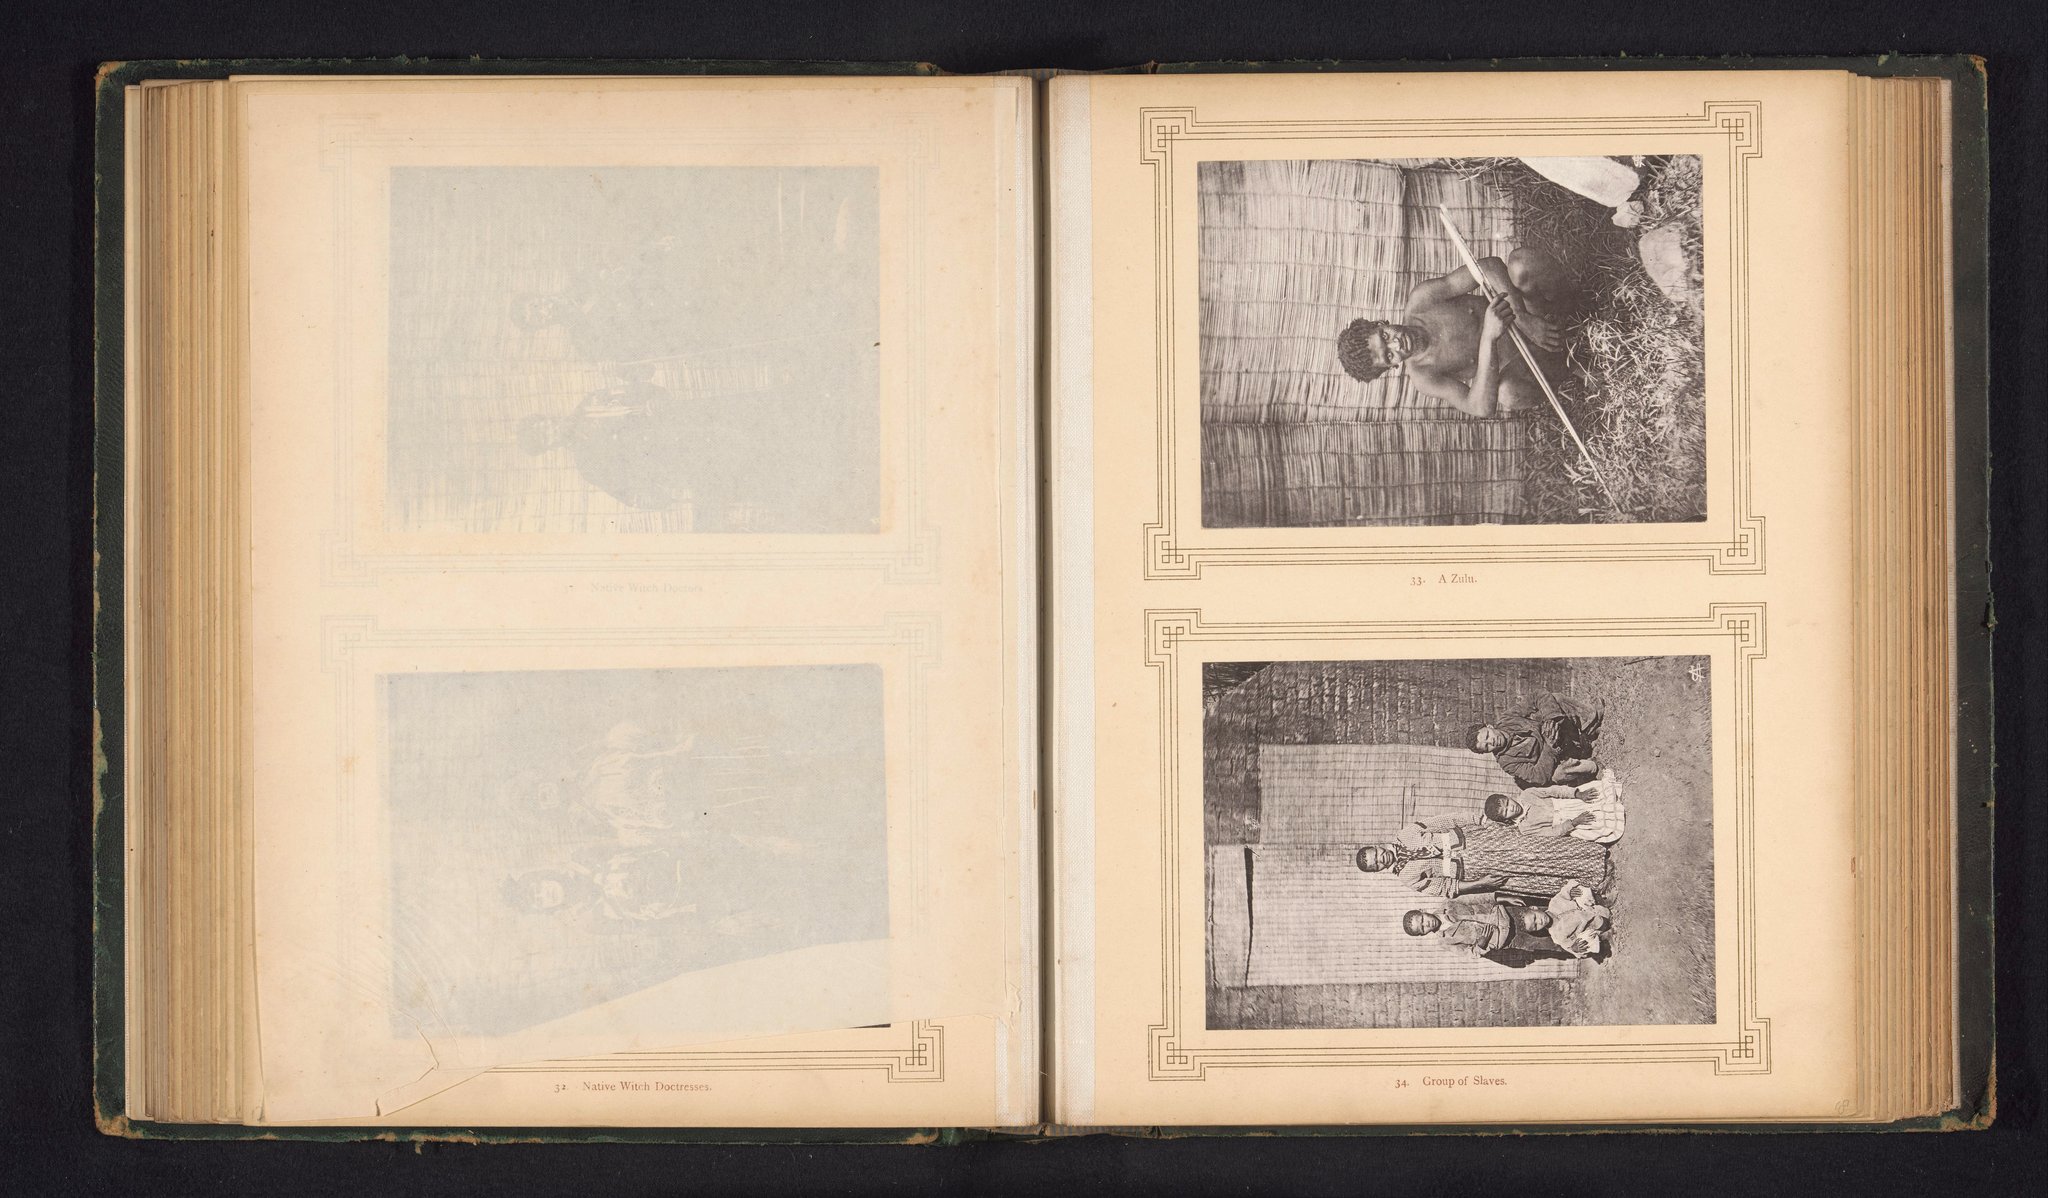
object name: photomechanical print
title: Group of slaves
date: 1870-1880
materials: paper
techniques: photograph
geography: south africa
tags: casting weapons: spear, slavery; serfs and enslaved persons, mother and child(ren), woman and child(ren) (family group), historical persons not known by name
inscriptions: number: ‘33. 34.’, inscription: ‘SA’